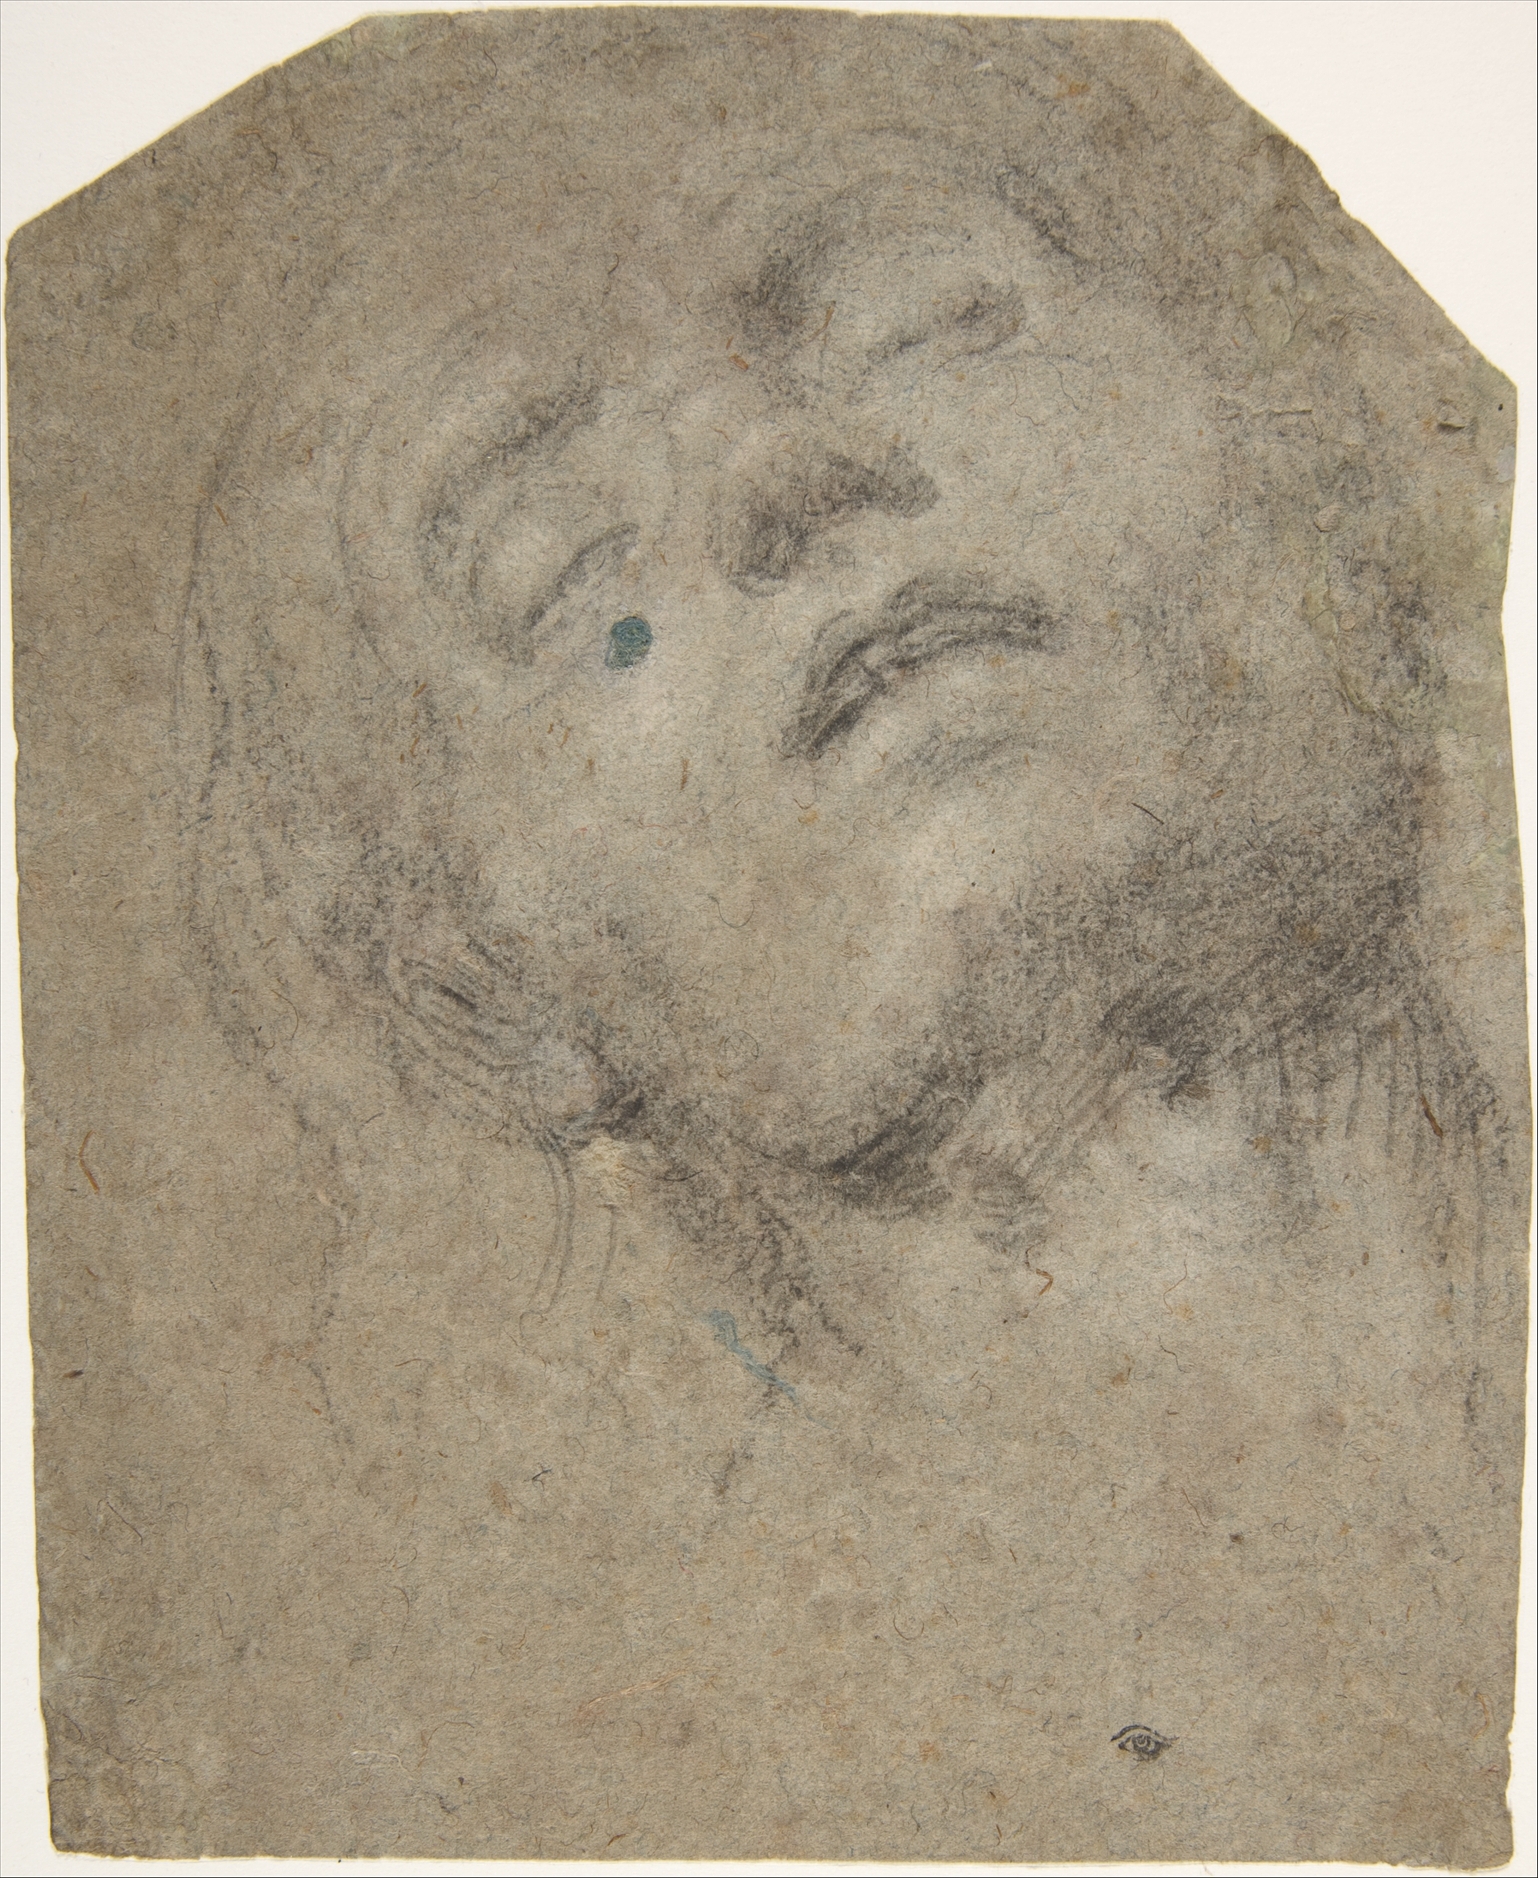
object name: drawing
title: Study of a Head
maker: giovanni gerolamo savoldo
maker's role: artist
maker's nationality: italian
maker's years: 1480-1548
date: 1508-1518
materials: chalk, paper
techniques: highlighting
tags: human figures,heads